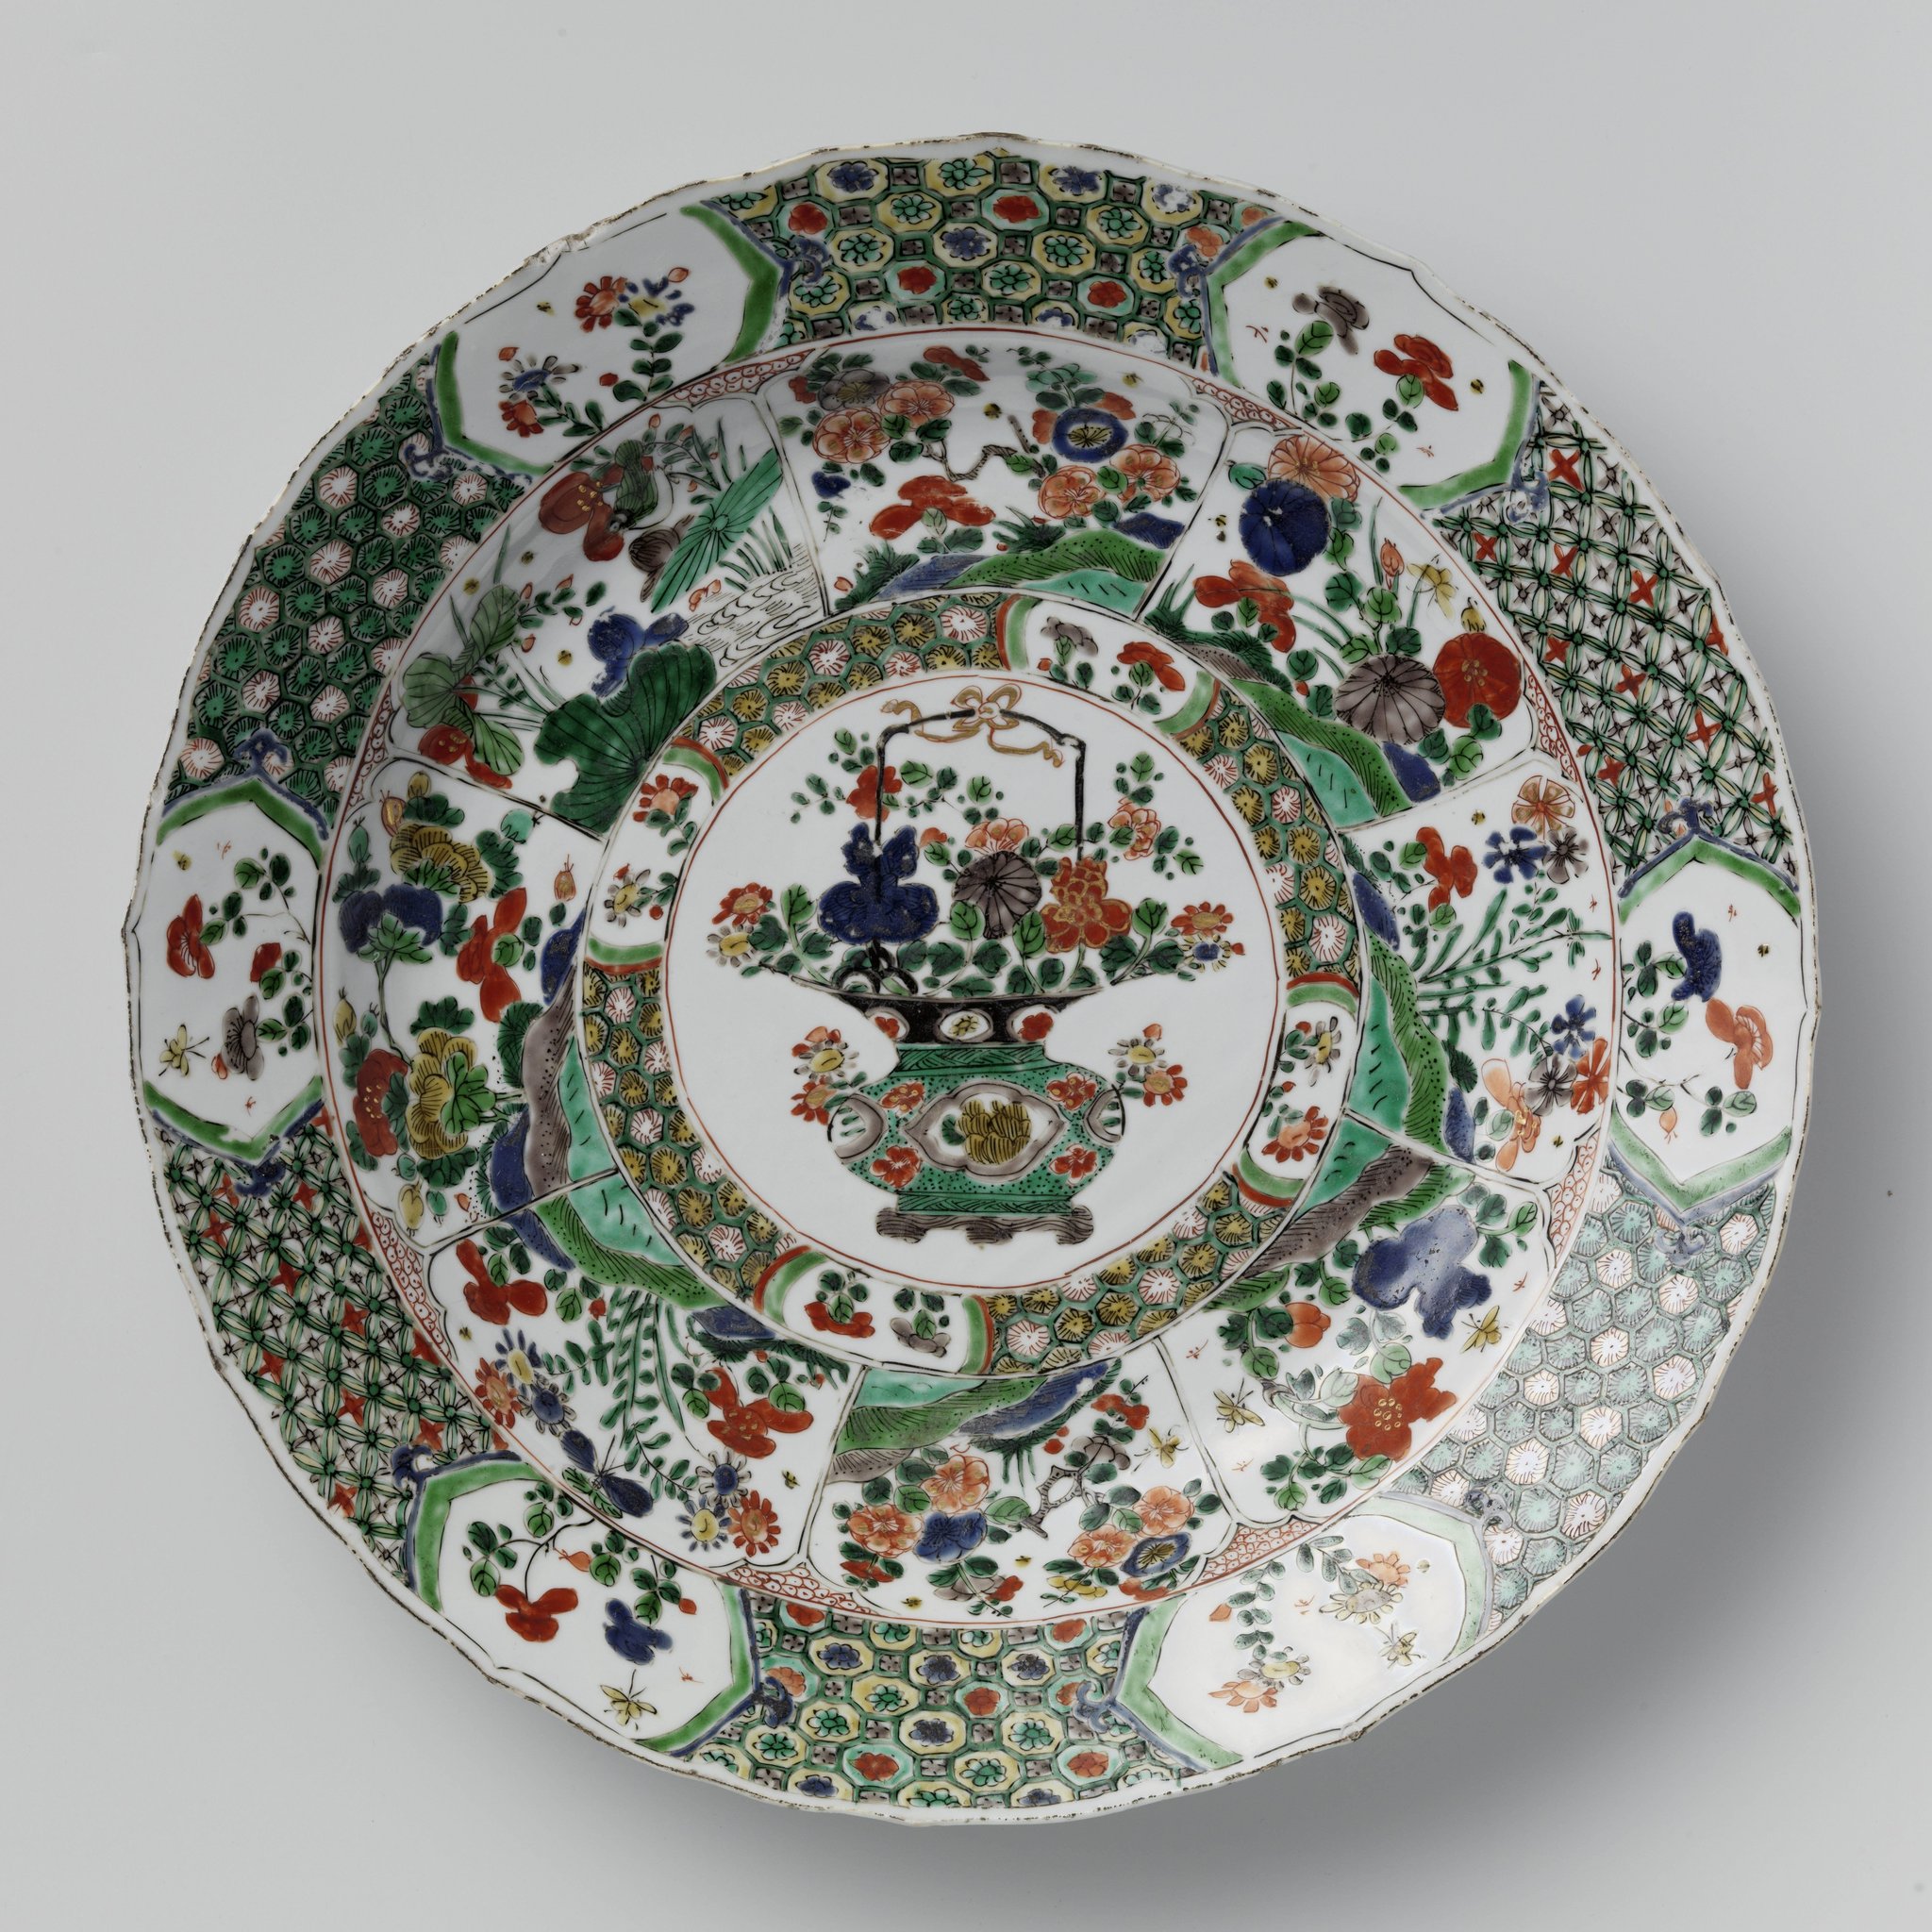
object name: platter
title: Dish with a flower basket, flowering plants and diaper patterns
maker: Anonymous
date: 1700-1724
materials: glaze, gold, paint, porcelain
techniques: firing, gilding, turning, vitrification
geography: china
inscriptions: mark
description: Schotel van porselein met een geschulpte rand, beschilderd op het glazuur in blauw, rood, groen, geel, aubergine, zwart en goud. Op het plat een bloemenmand in een medaillon; hieromheen een band met servetwerk onderbroken door bloemtakken in cartouches. De wand is verdeeld in acht vakken met bloeiende planten (lotus, chrysant, prunus, aster, pioen, prachtanjer, camelia). Op de rand servetwerk onderbroken door cartouches met bloemtakken. De achterzijde met drie bloemtakken. Gemerkt op de onderzijde met een artemisiablad in een dubbele cirkel. Enkele chips in de rand. Famille verte.